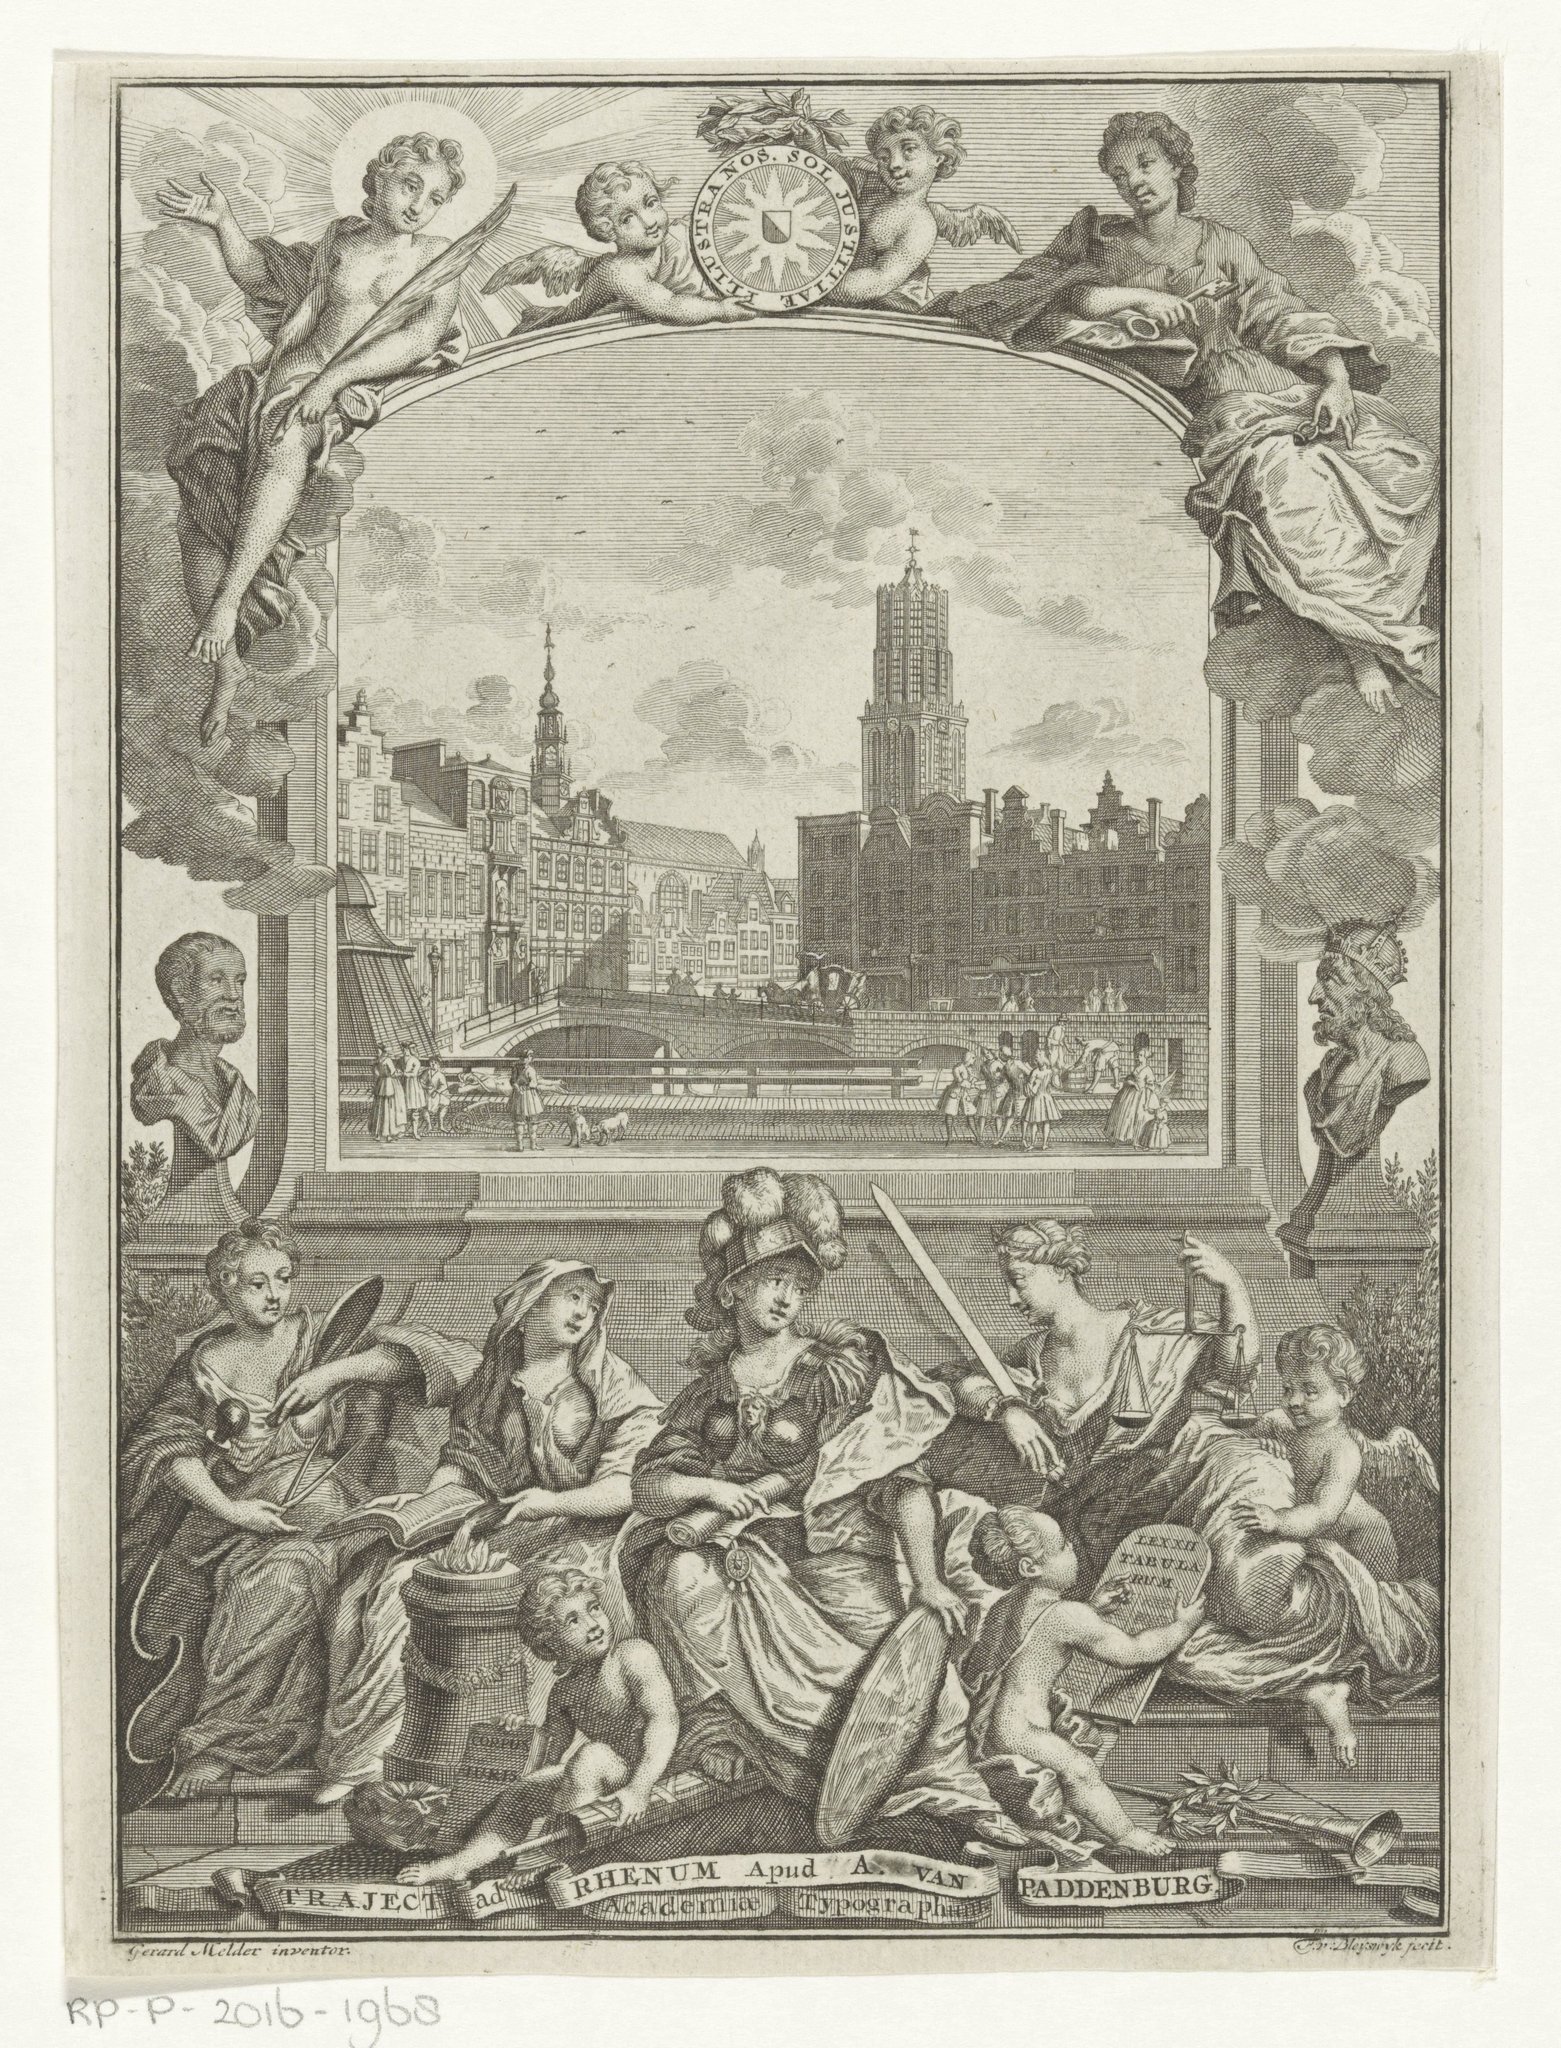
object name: print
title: Stadsgezicht met Domkerk te Utrecht en allegorie met Minerva en deugden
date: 1750-1790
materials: paper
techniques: etching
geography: utrecht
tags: temperance, 'temperantia'; 'temperanza' (ripa) ~ one of the four cardinal virtues, justice, 'justitia'; 'giustitia divina' (ripa) ~ one of the four cardinal virtues, prudence, 'prudentia'; 'prudenza' (ripa) ~ one of the four cardinal virtues, (story of) minerva (pallas, athena), utrecht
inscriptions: collector's mark: Lugt 2228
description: Een stadsgezicht met de Domkerk te Utrecht staat centraal in een omlijsting met Minerva in gezelschap van drie deugden: Voorzichtigheid, Matigheid en Rechtvaardigheid. De lijst wordt bekroond met personificaties van waarheid en trouw aan weerszijden van twee putti met een schild met wapen en motto van de Utrechtse universiteit.